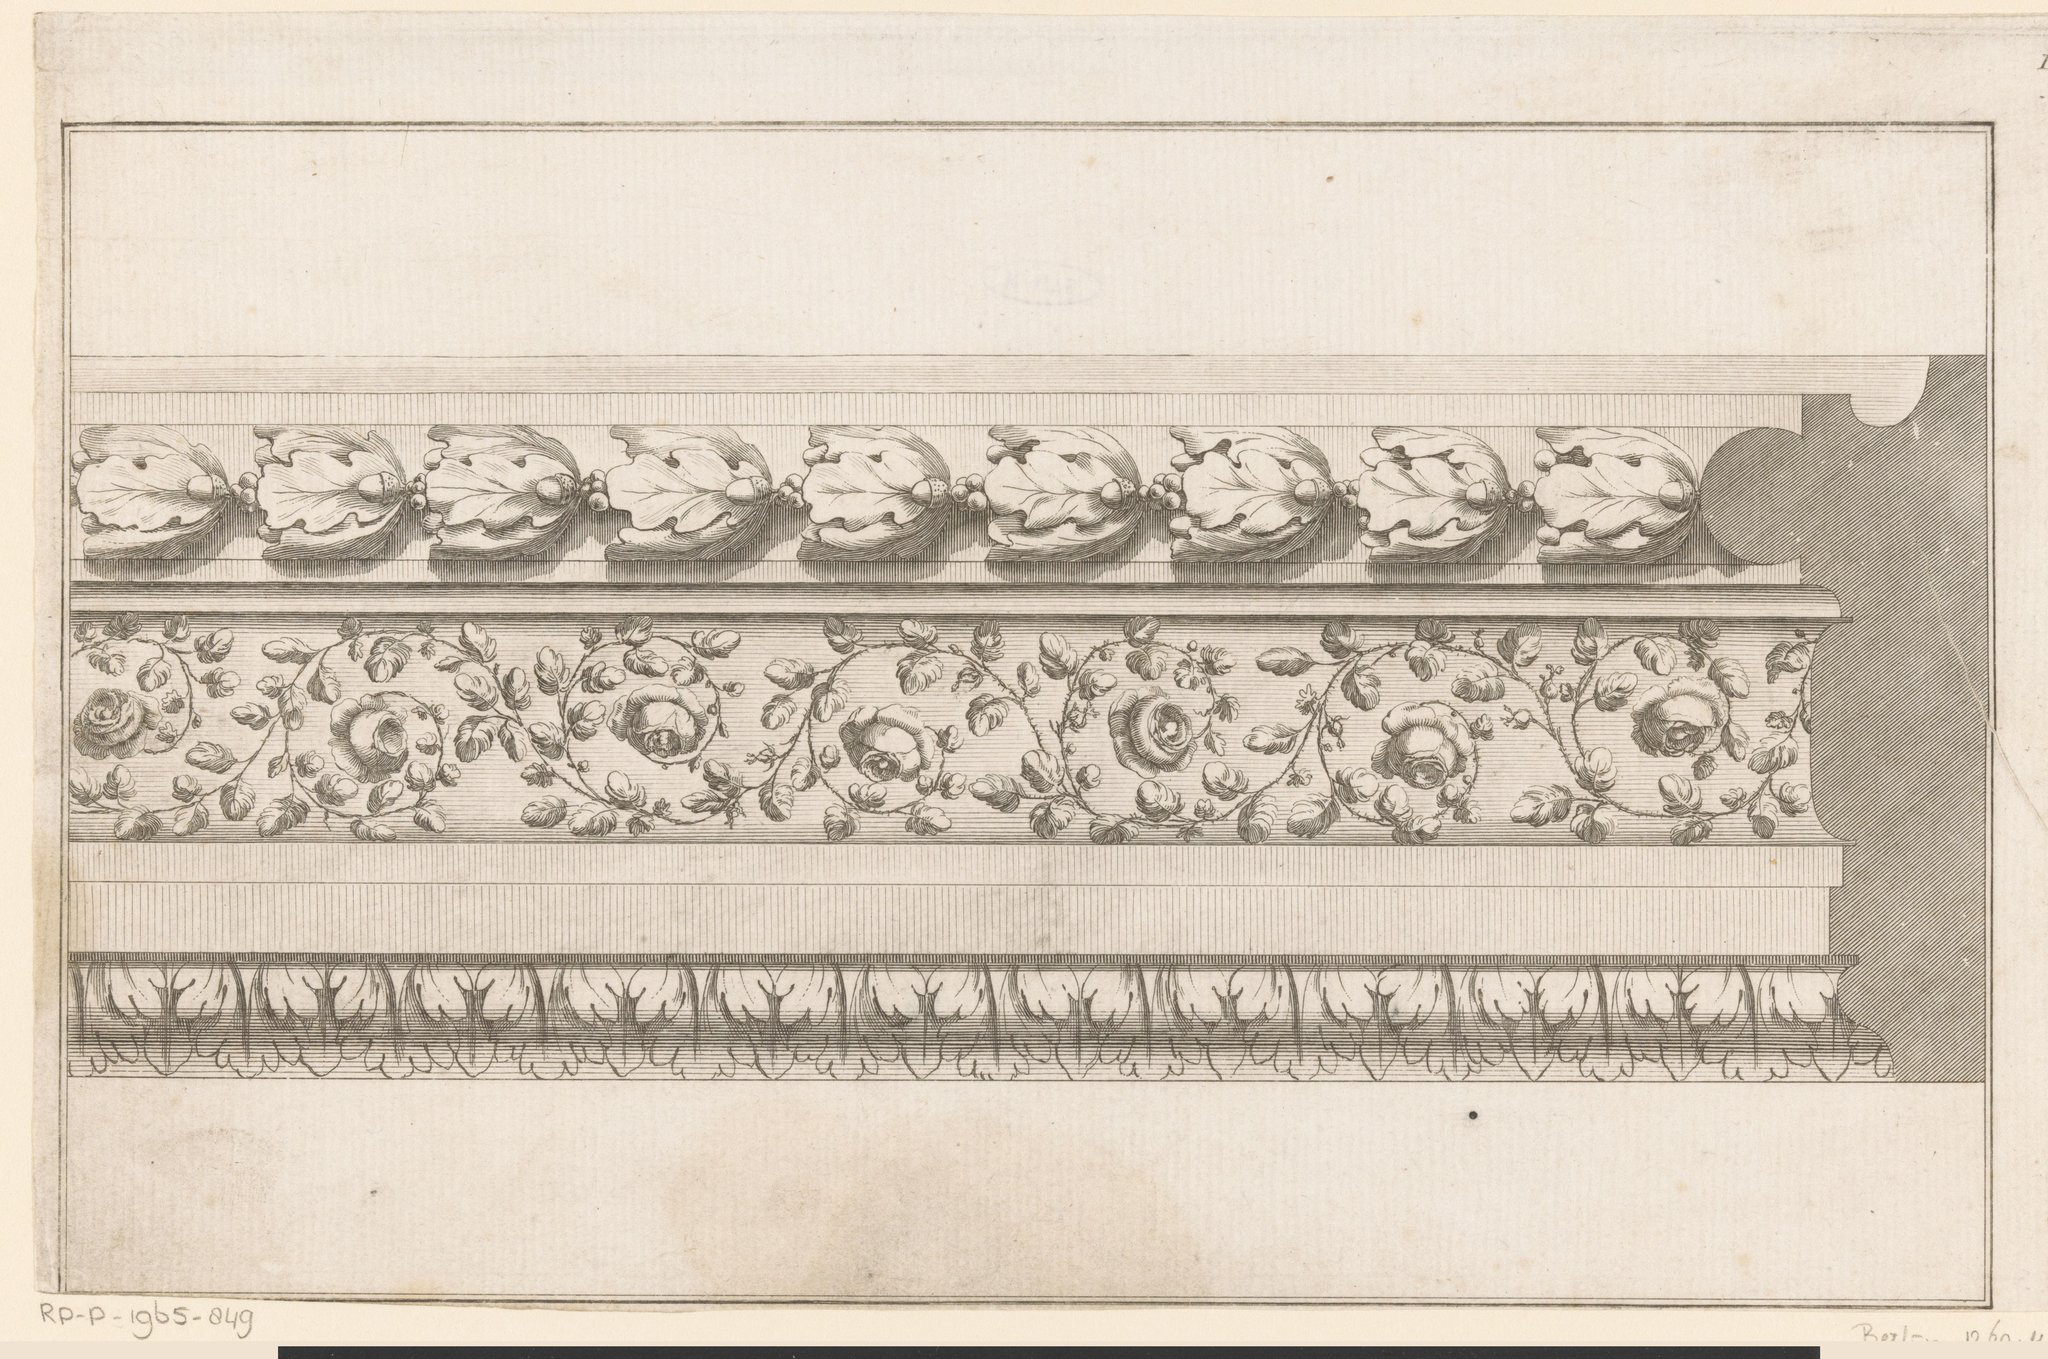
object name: ornament print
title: Lijst met eikenbladeren en rozen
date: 1784-1785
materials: paper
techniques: engraving, etching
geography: paris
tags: ornaments ~ art (+ framing decorations)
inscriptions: collector's mark: Lugt 2760, collector's mark: Lugt 2228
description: Een geornamenteerde lijst met eikenbladeren, ranken met rozen en acanthusbladeren.